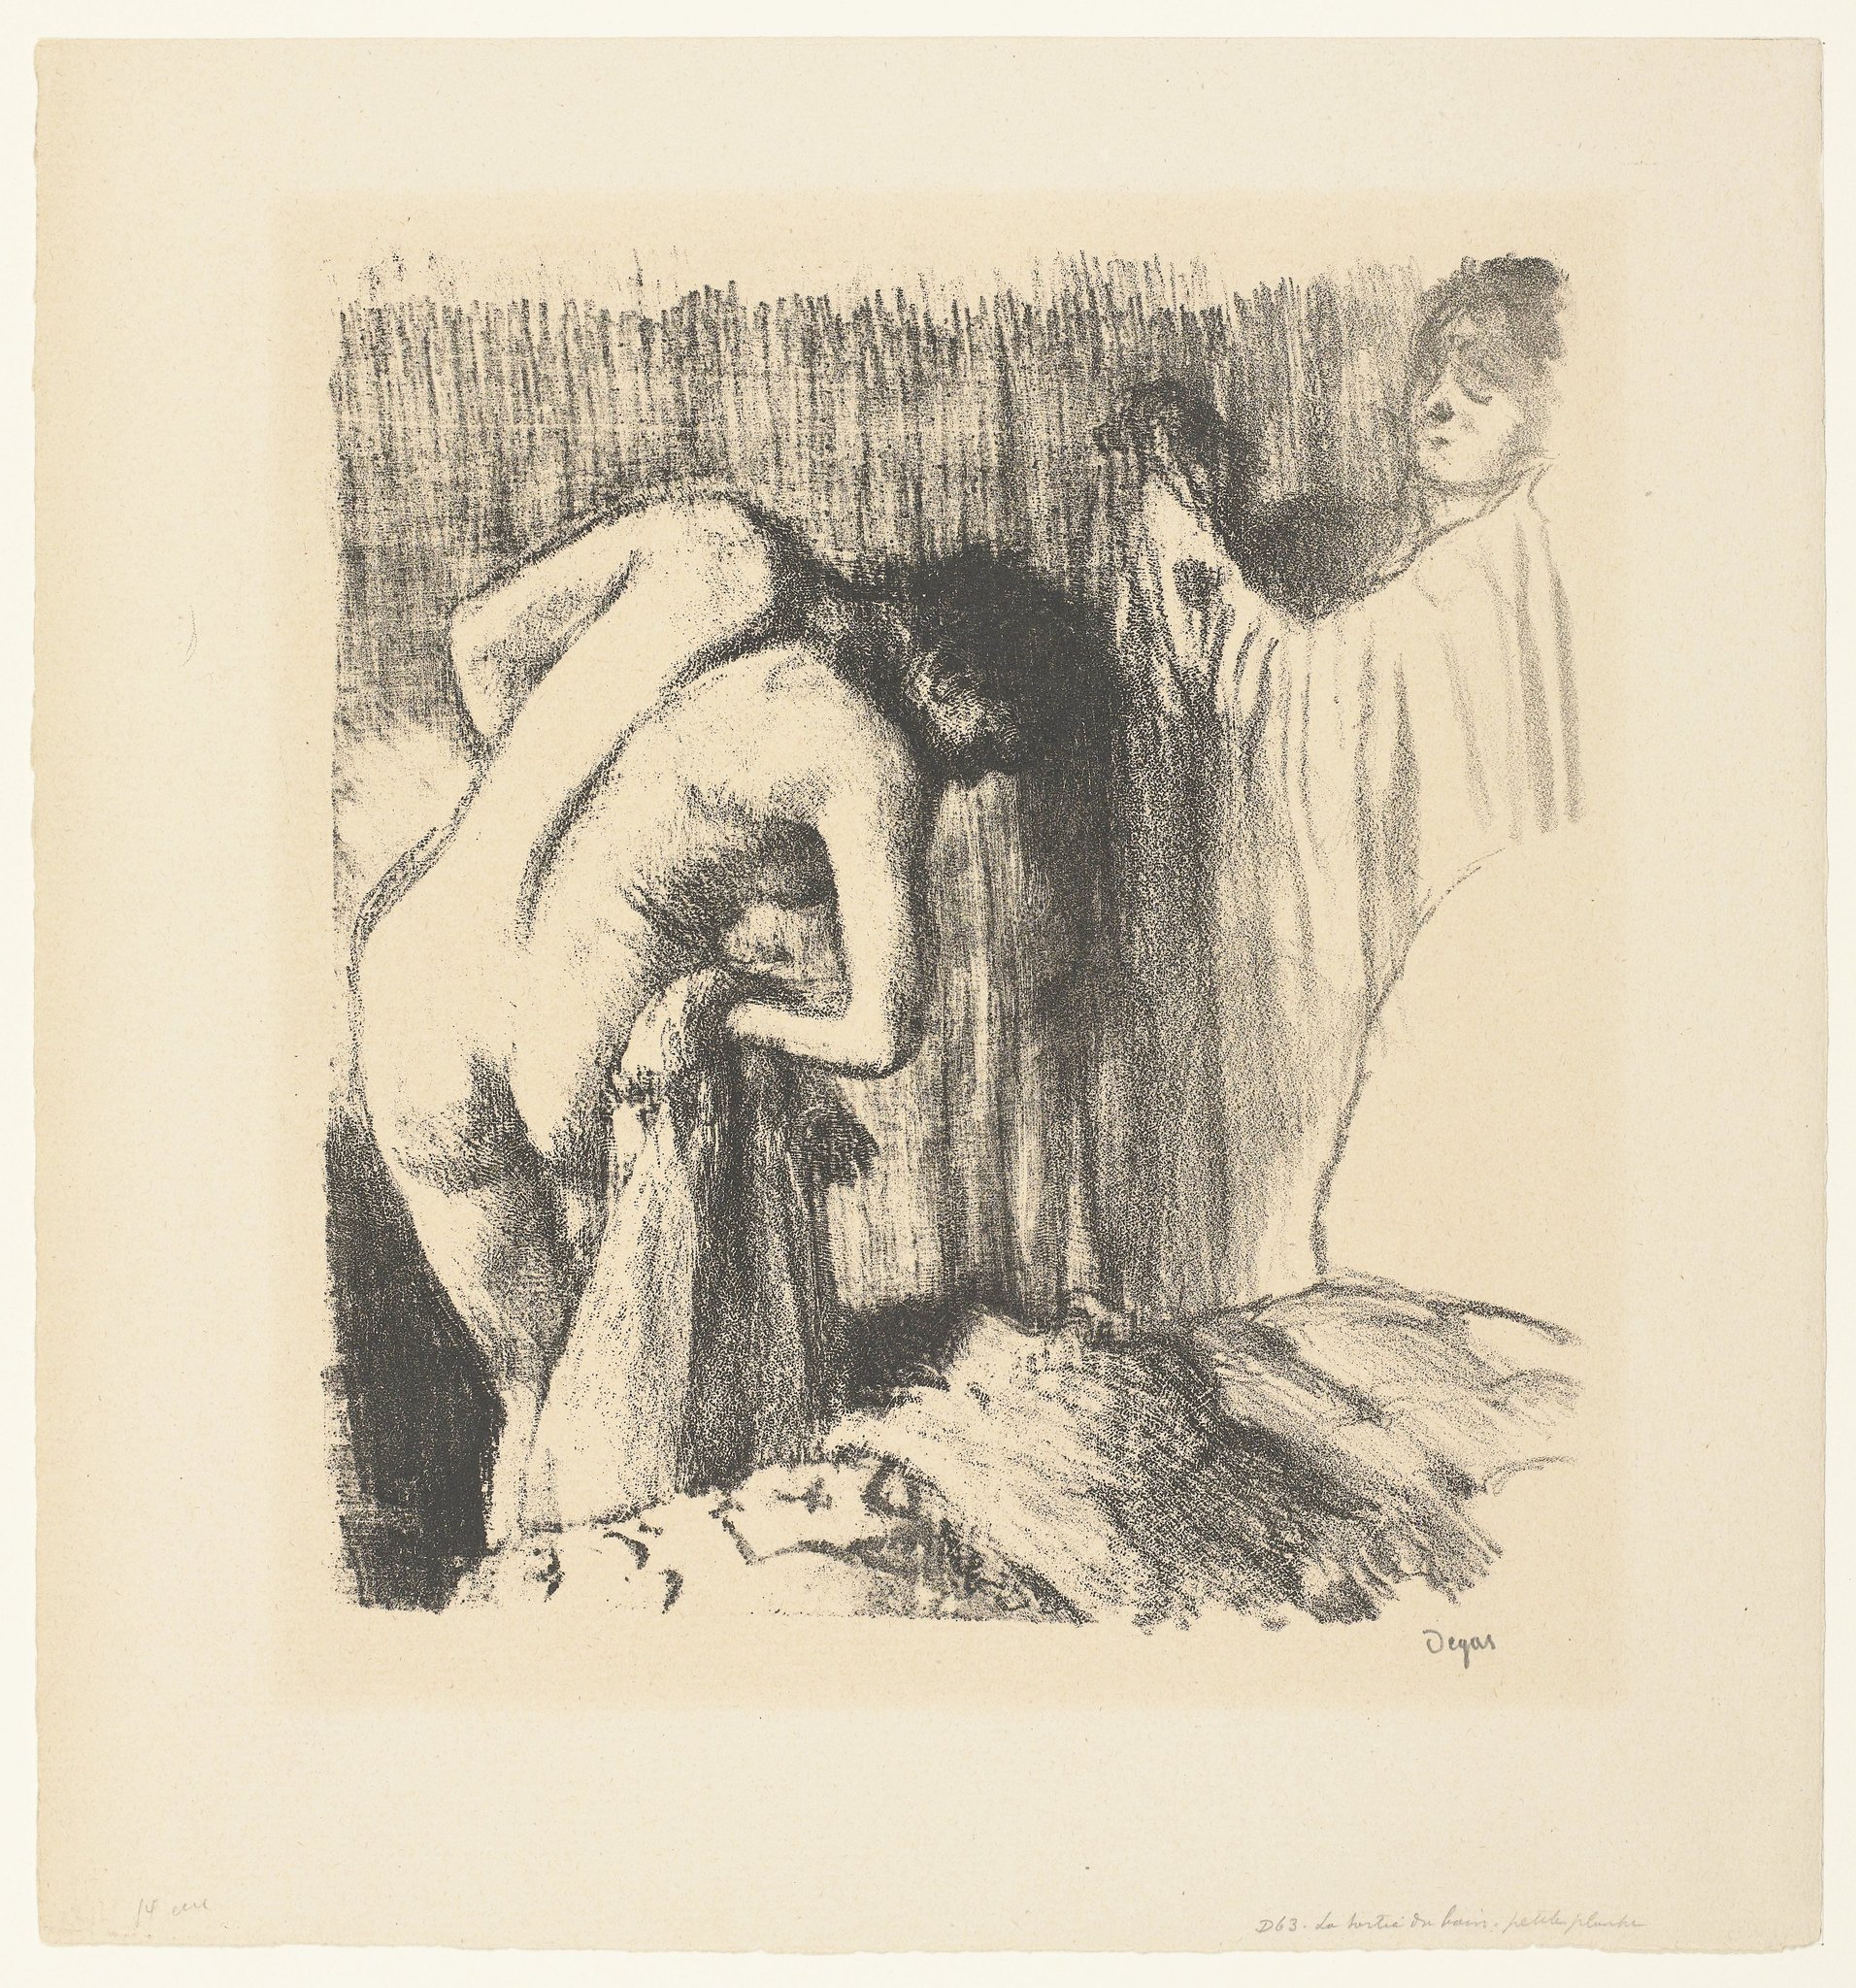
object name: print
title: Vrouw droogt zich af na haar bad en krijgt kleding aangereikt van vrouw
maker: edgar degas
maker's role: draughtsman, painter, print maker, sculptor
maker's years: 1834-1917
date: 1891-1892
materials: paper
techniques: lithograph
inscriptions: stamp: ‘Douanes Paris exposition’, collector's mark: Lugt 2228